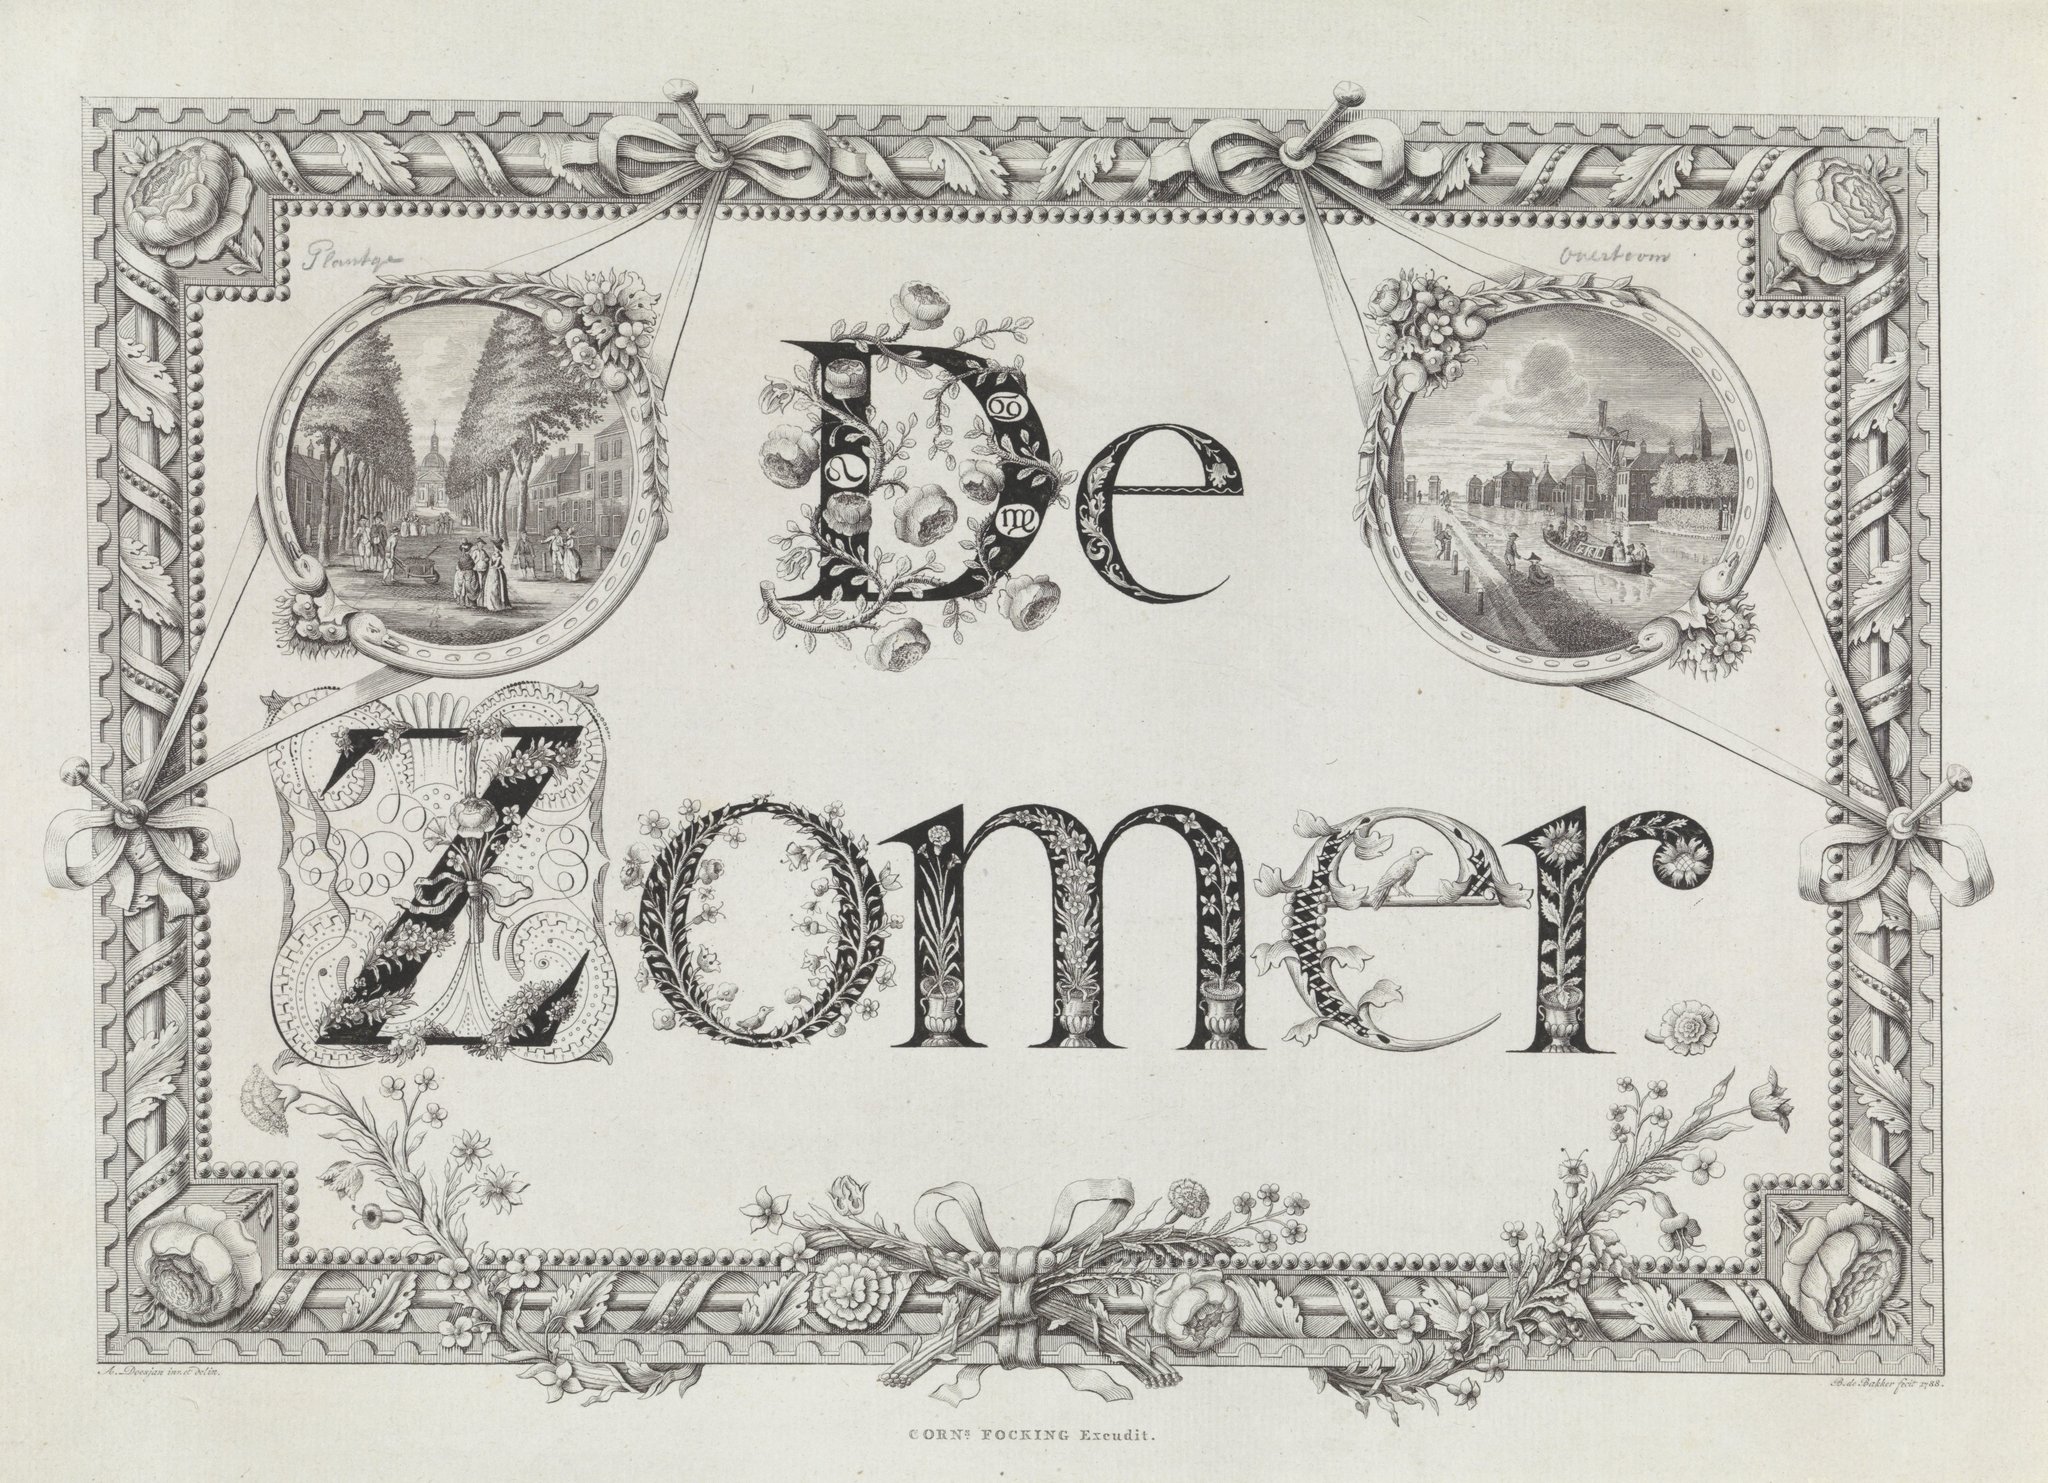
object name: print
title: De Zomer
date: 1762-1804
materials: paper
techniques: engraving, etching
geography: amsterdam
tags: summer, 'aestas'; 'estate' (ripa)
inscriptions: collector's mark: Lugt 2228